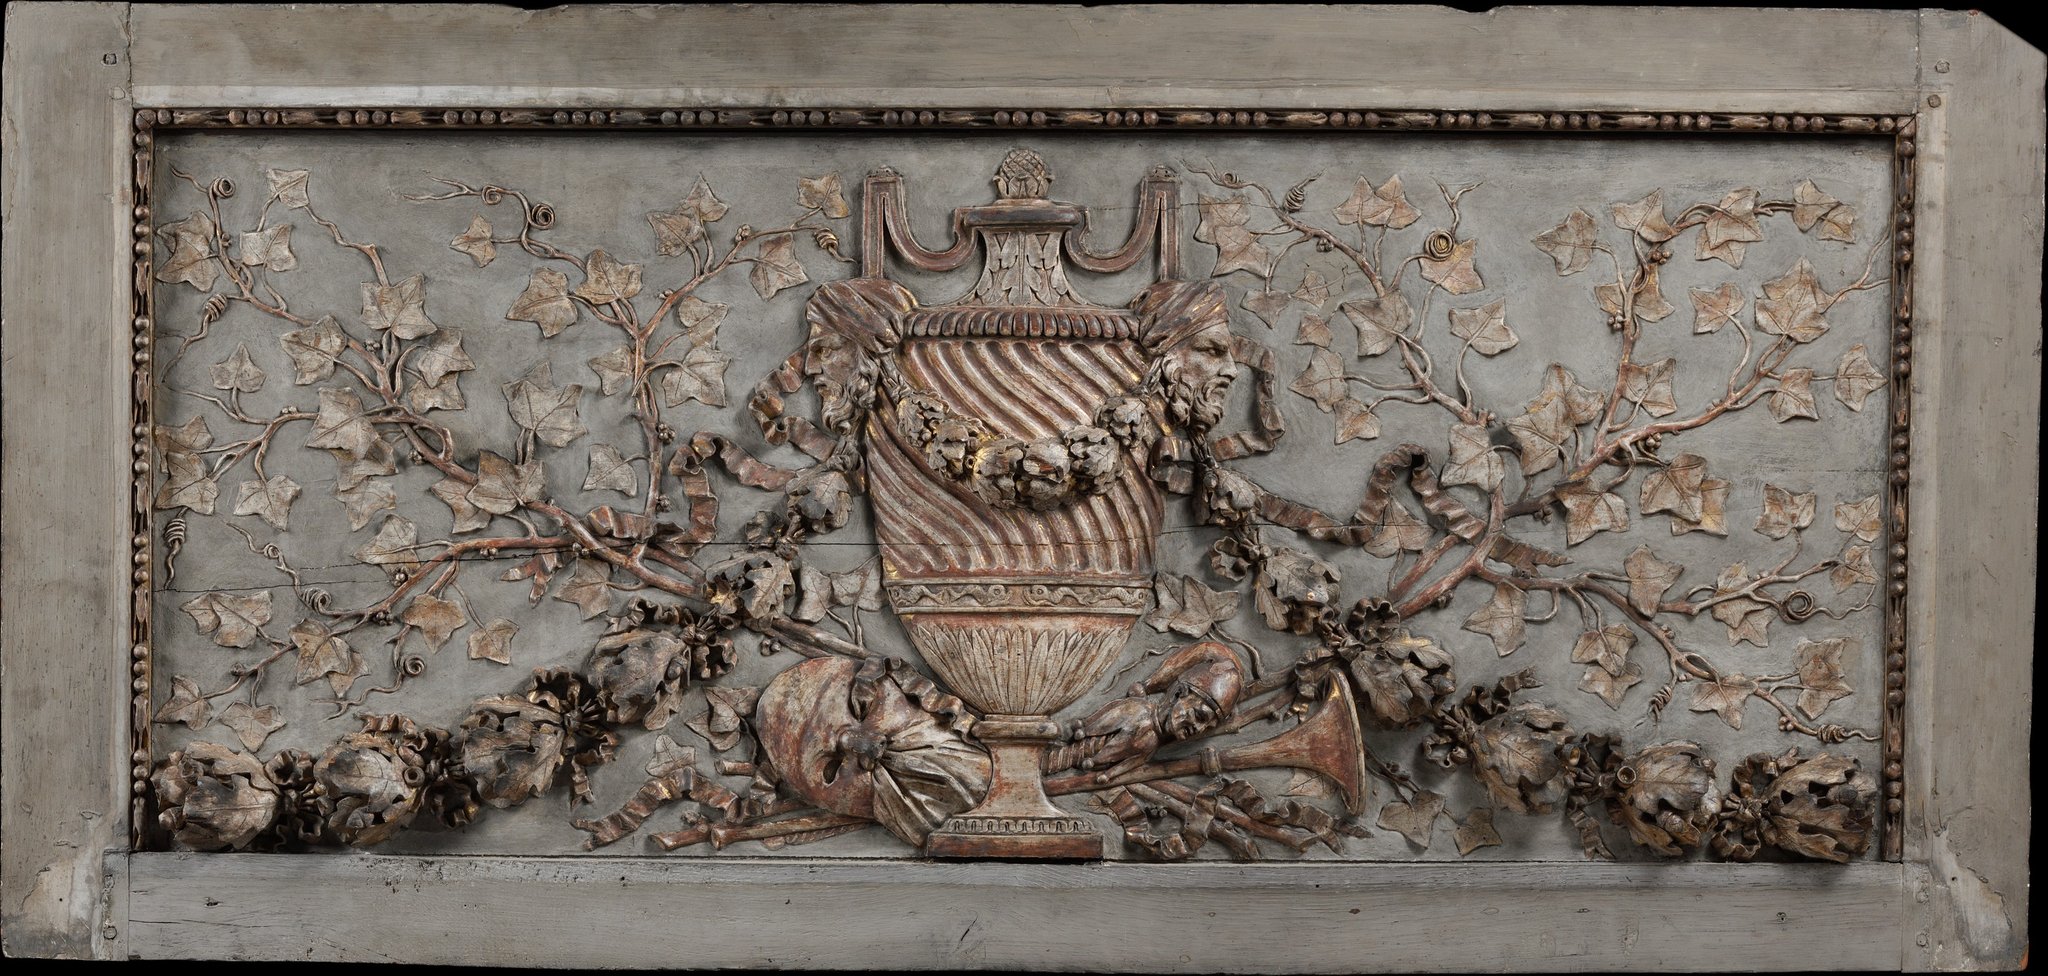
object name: panel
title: Winter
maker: françois joseph belanger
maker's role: maker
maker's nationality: french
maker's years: 1744-1818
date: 1775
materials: gilt, wood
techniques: carving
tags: musical instruments,profiles